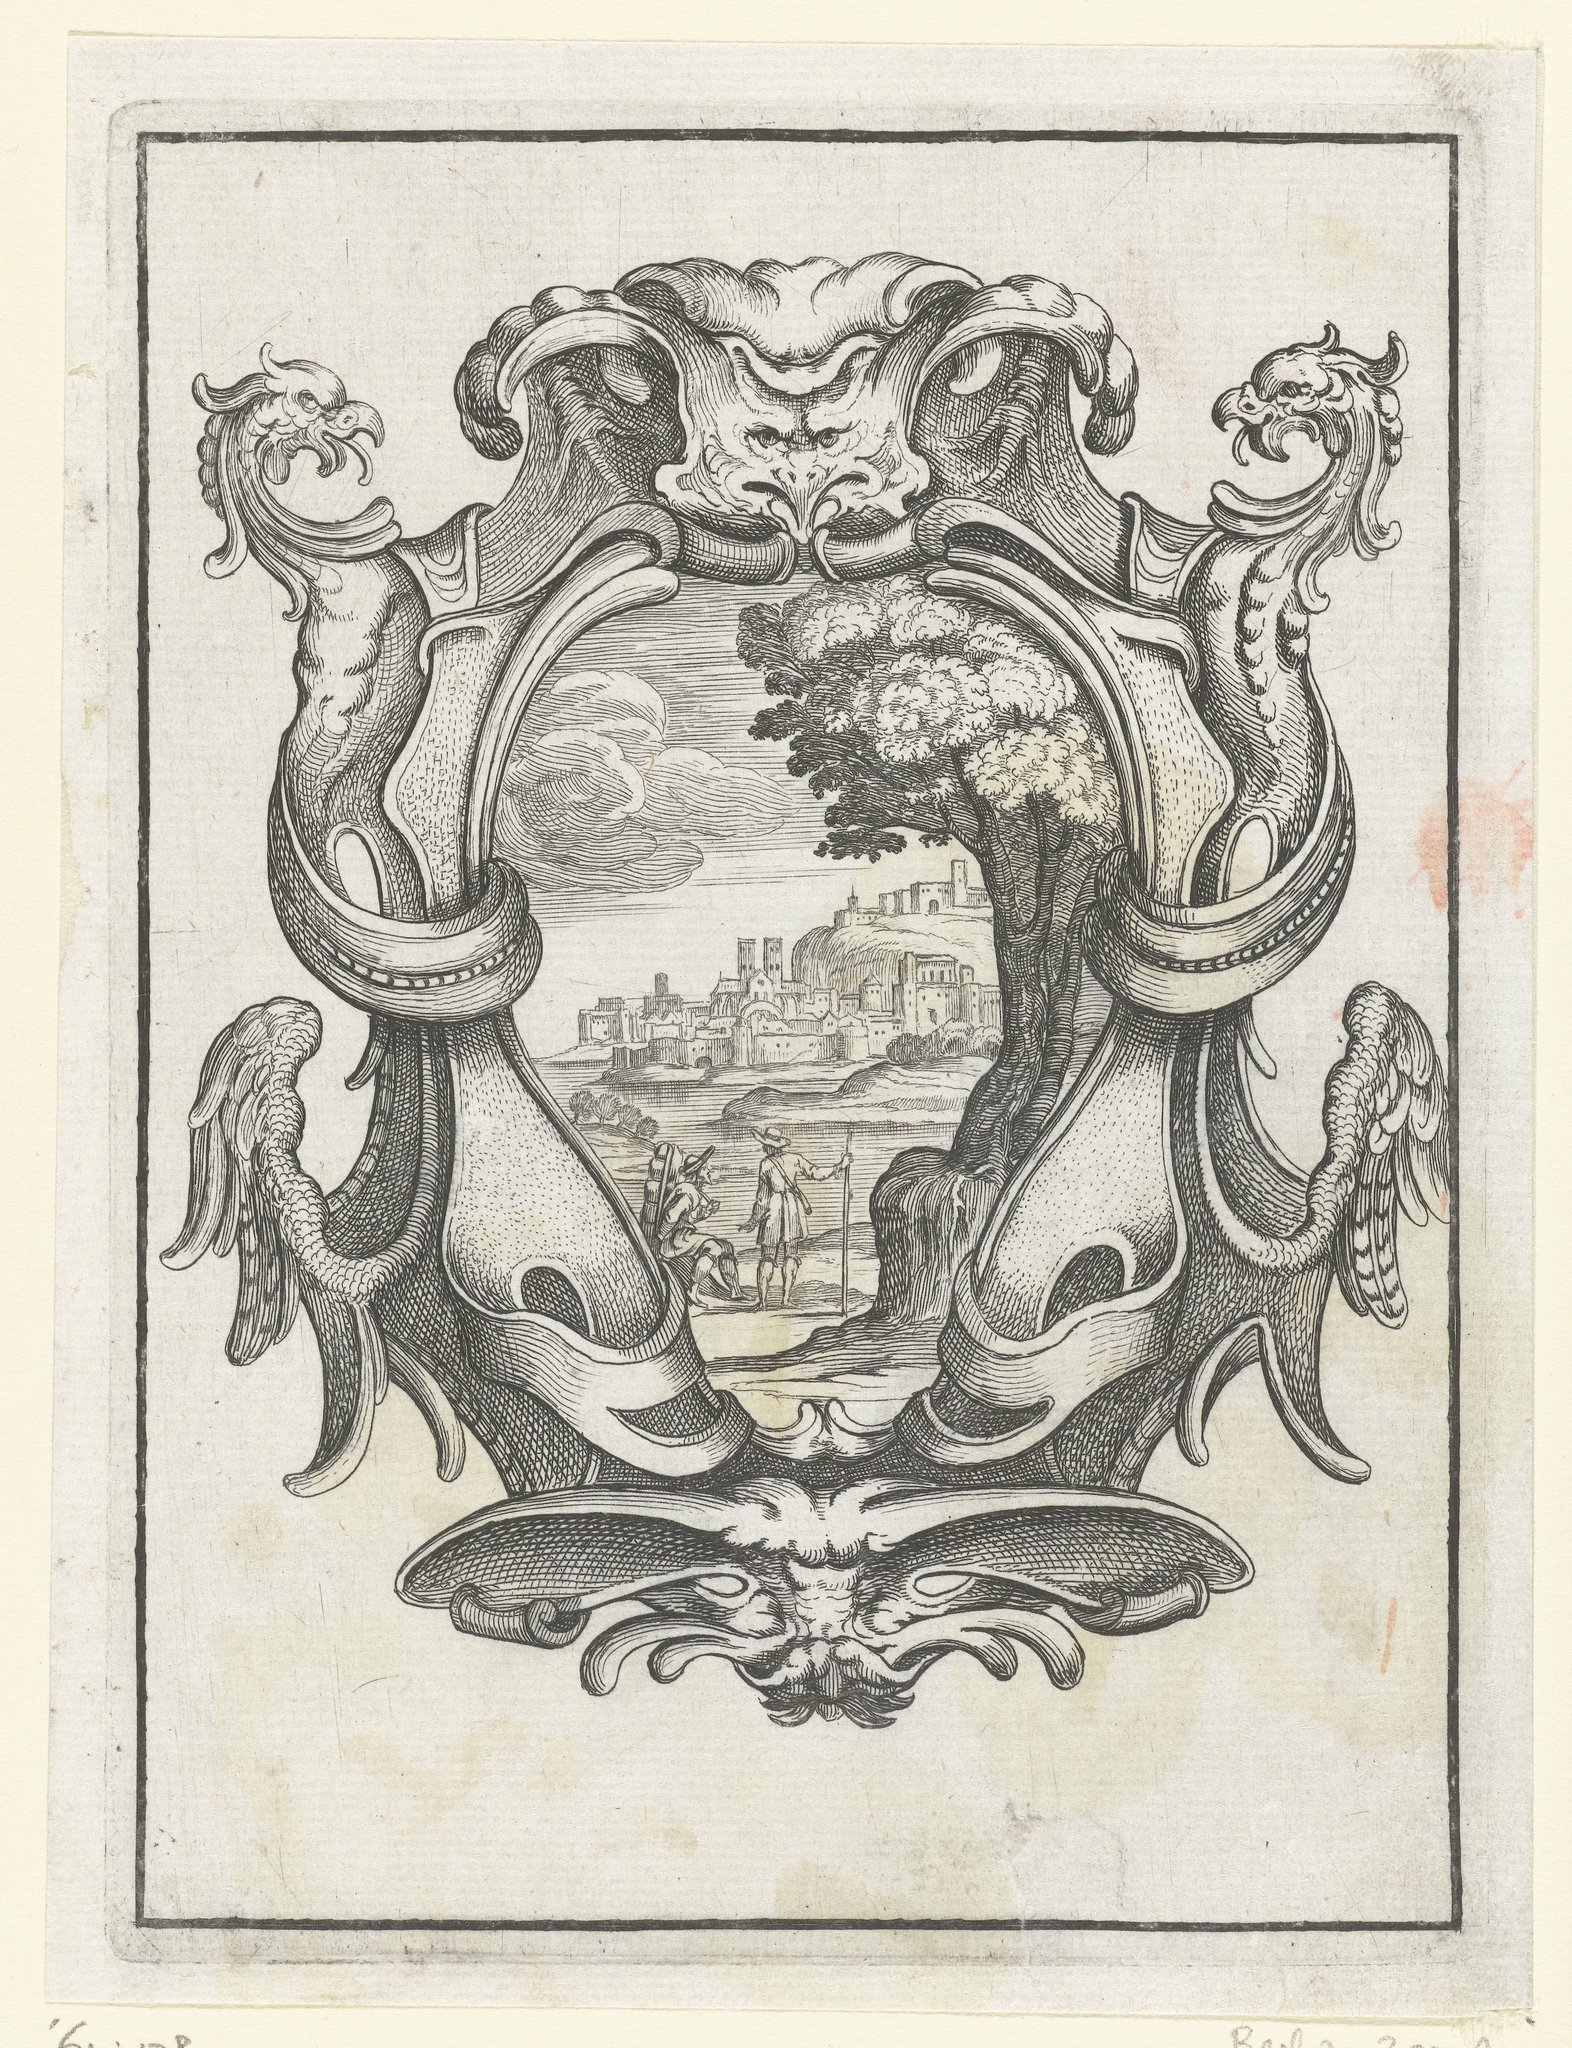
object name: print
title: Cartouche met drakenkoppen en vleugels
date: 1632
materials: paper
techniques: engraving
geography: france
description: In de cartouche is een vestingstad op het water afgebeeld. Blad 2 uit serie van 13 bladen met cartouches in Franse kwabstijl.